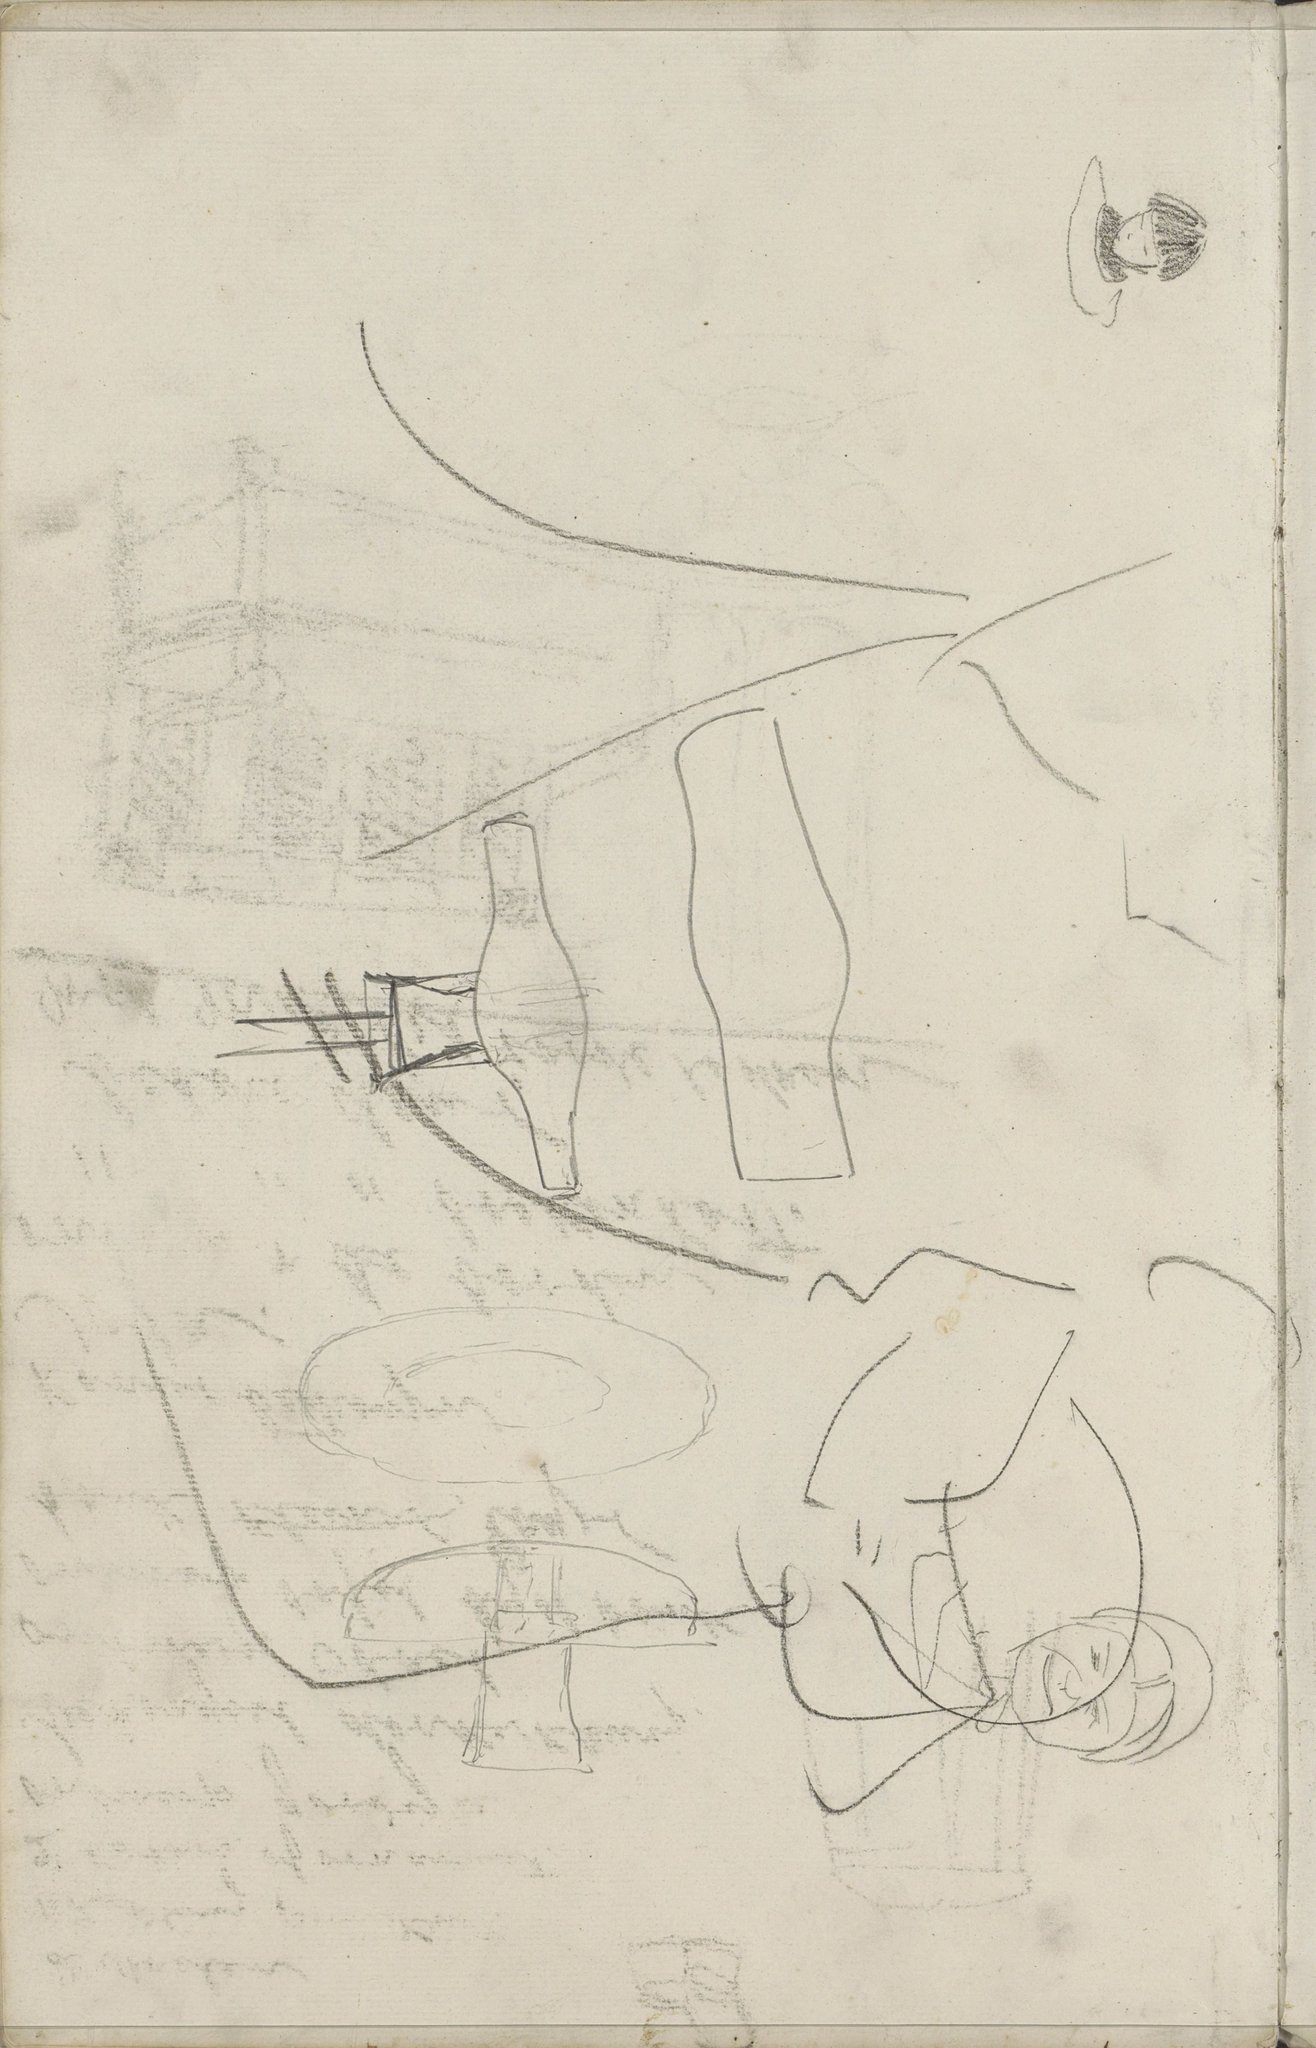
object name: sketchbook leaf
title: Koppen en studies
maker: carel adolph lion cachet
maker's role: draughtsman, print maker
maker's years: 1864-1945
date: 1895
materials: chalk, paper, pencil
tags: head (human)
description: Blad 22 verso uit een schetsboek met 23 bladen.